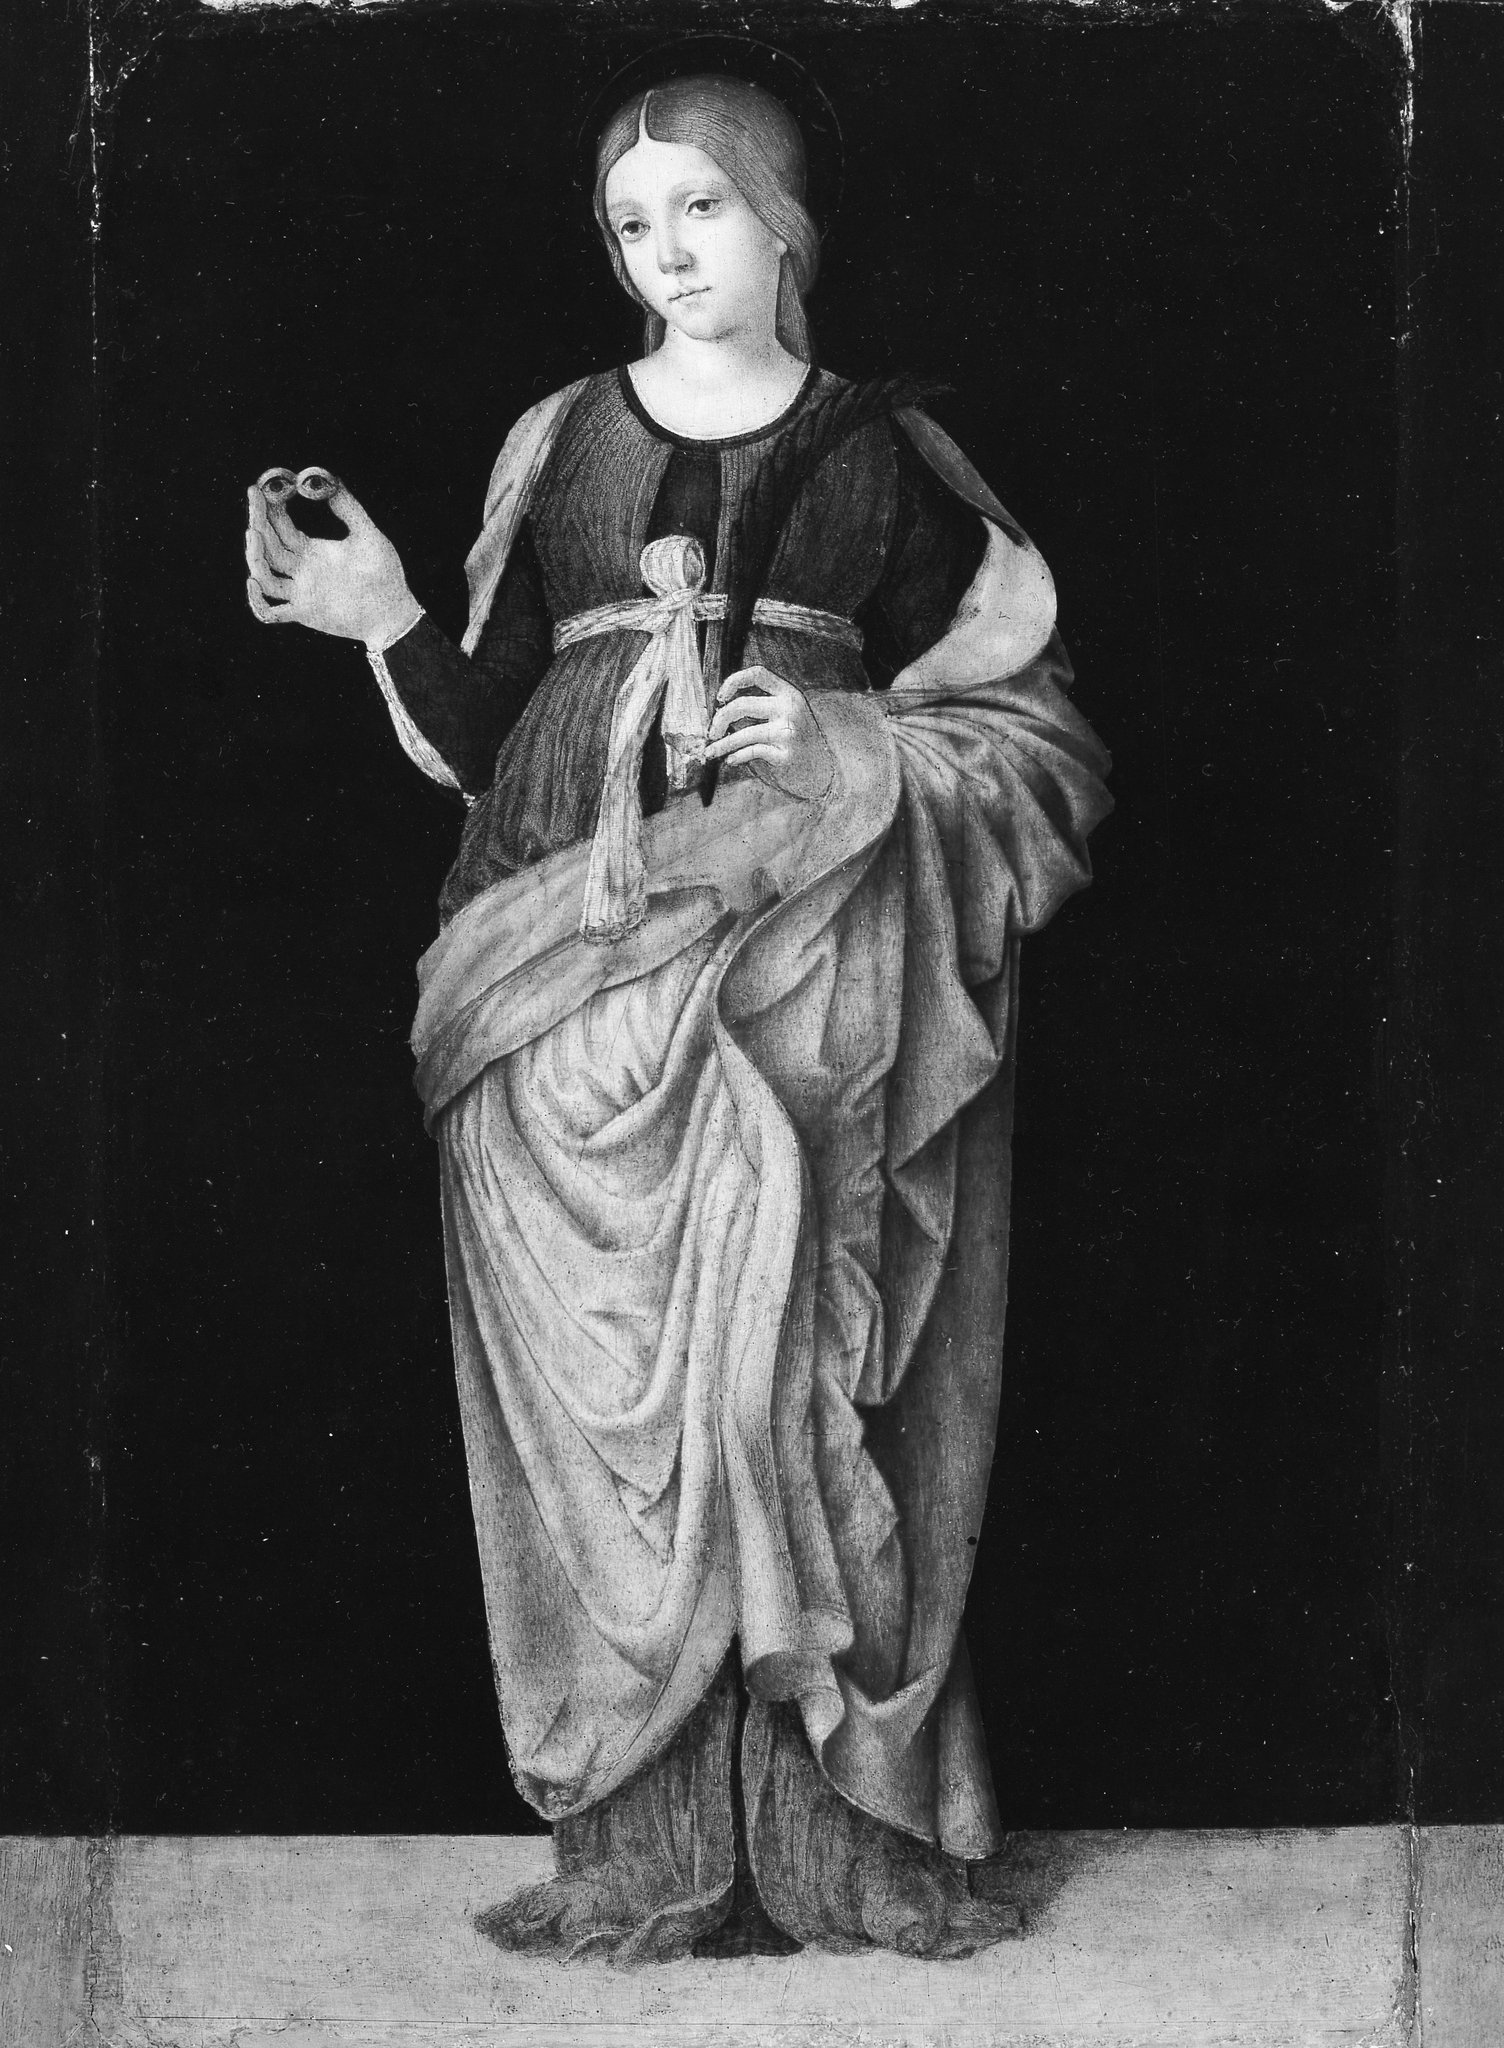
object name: painting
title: Saint Lucy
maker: francesco zaganelli (francesco di bosio)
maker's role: artist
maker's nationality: italian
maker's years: 1499-1532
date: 1499-1532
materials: gold, paint, wood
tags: portraits,women,saints